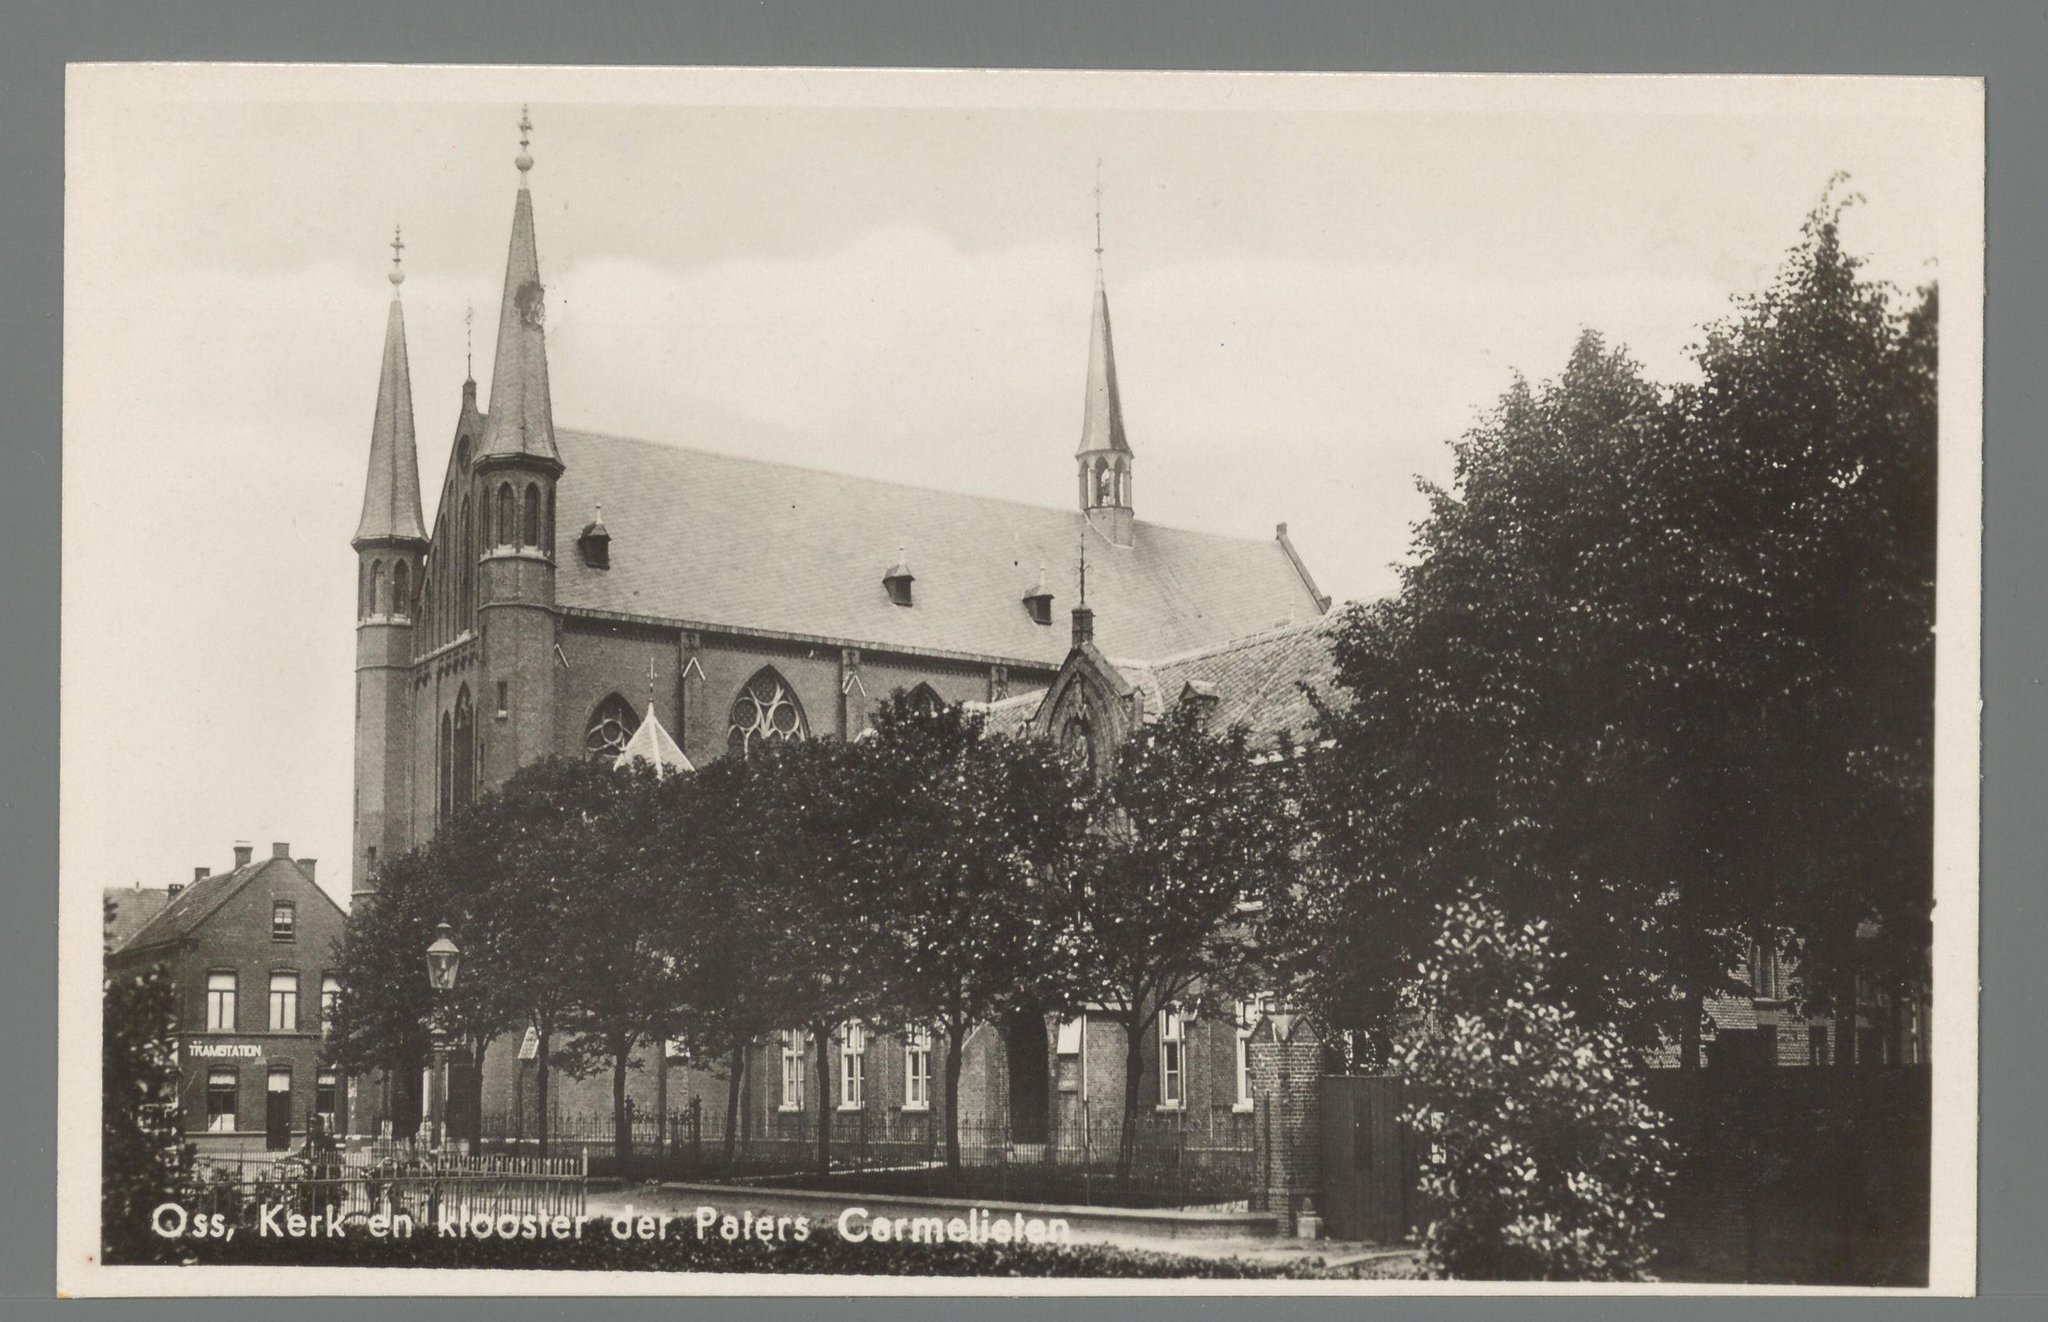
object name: ansichtkaart, prentbriefkaart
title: Oss, kerk en klooster der Paters Carmelieten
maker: Anonymous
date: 1909-1940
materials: paper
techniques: gelatin silver print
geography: oss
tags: abbey, monastery, convent ~ roman catholic church, church (exterior), oss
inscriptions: date